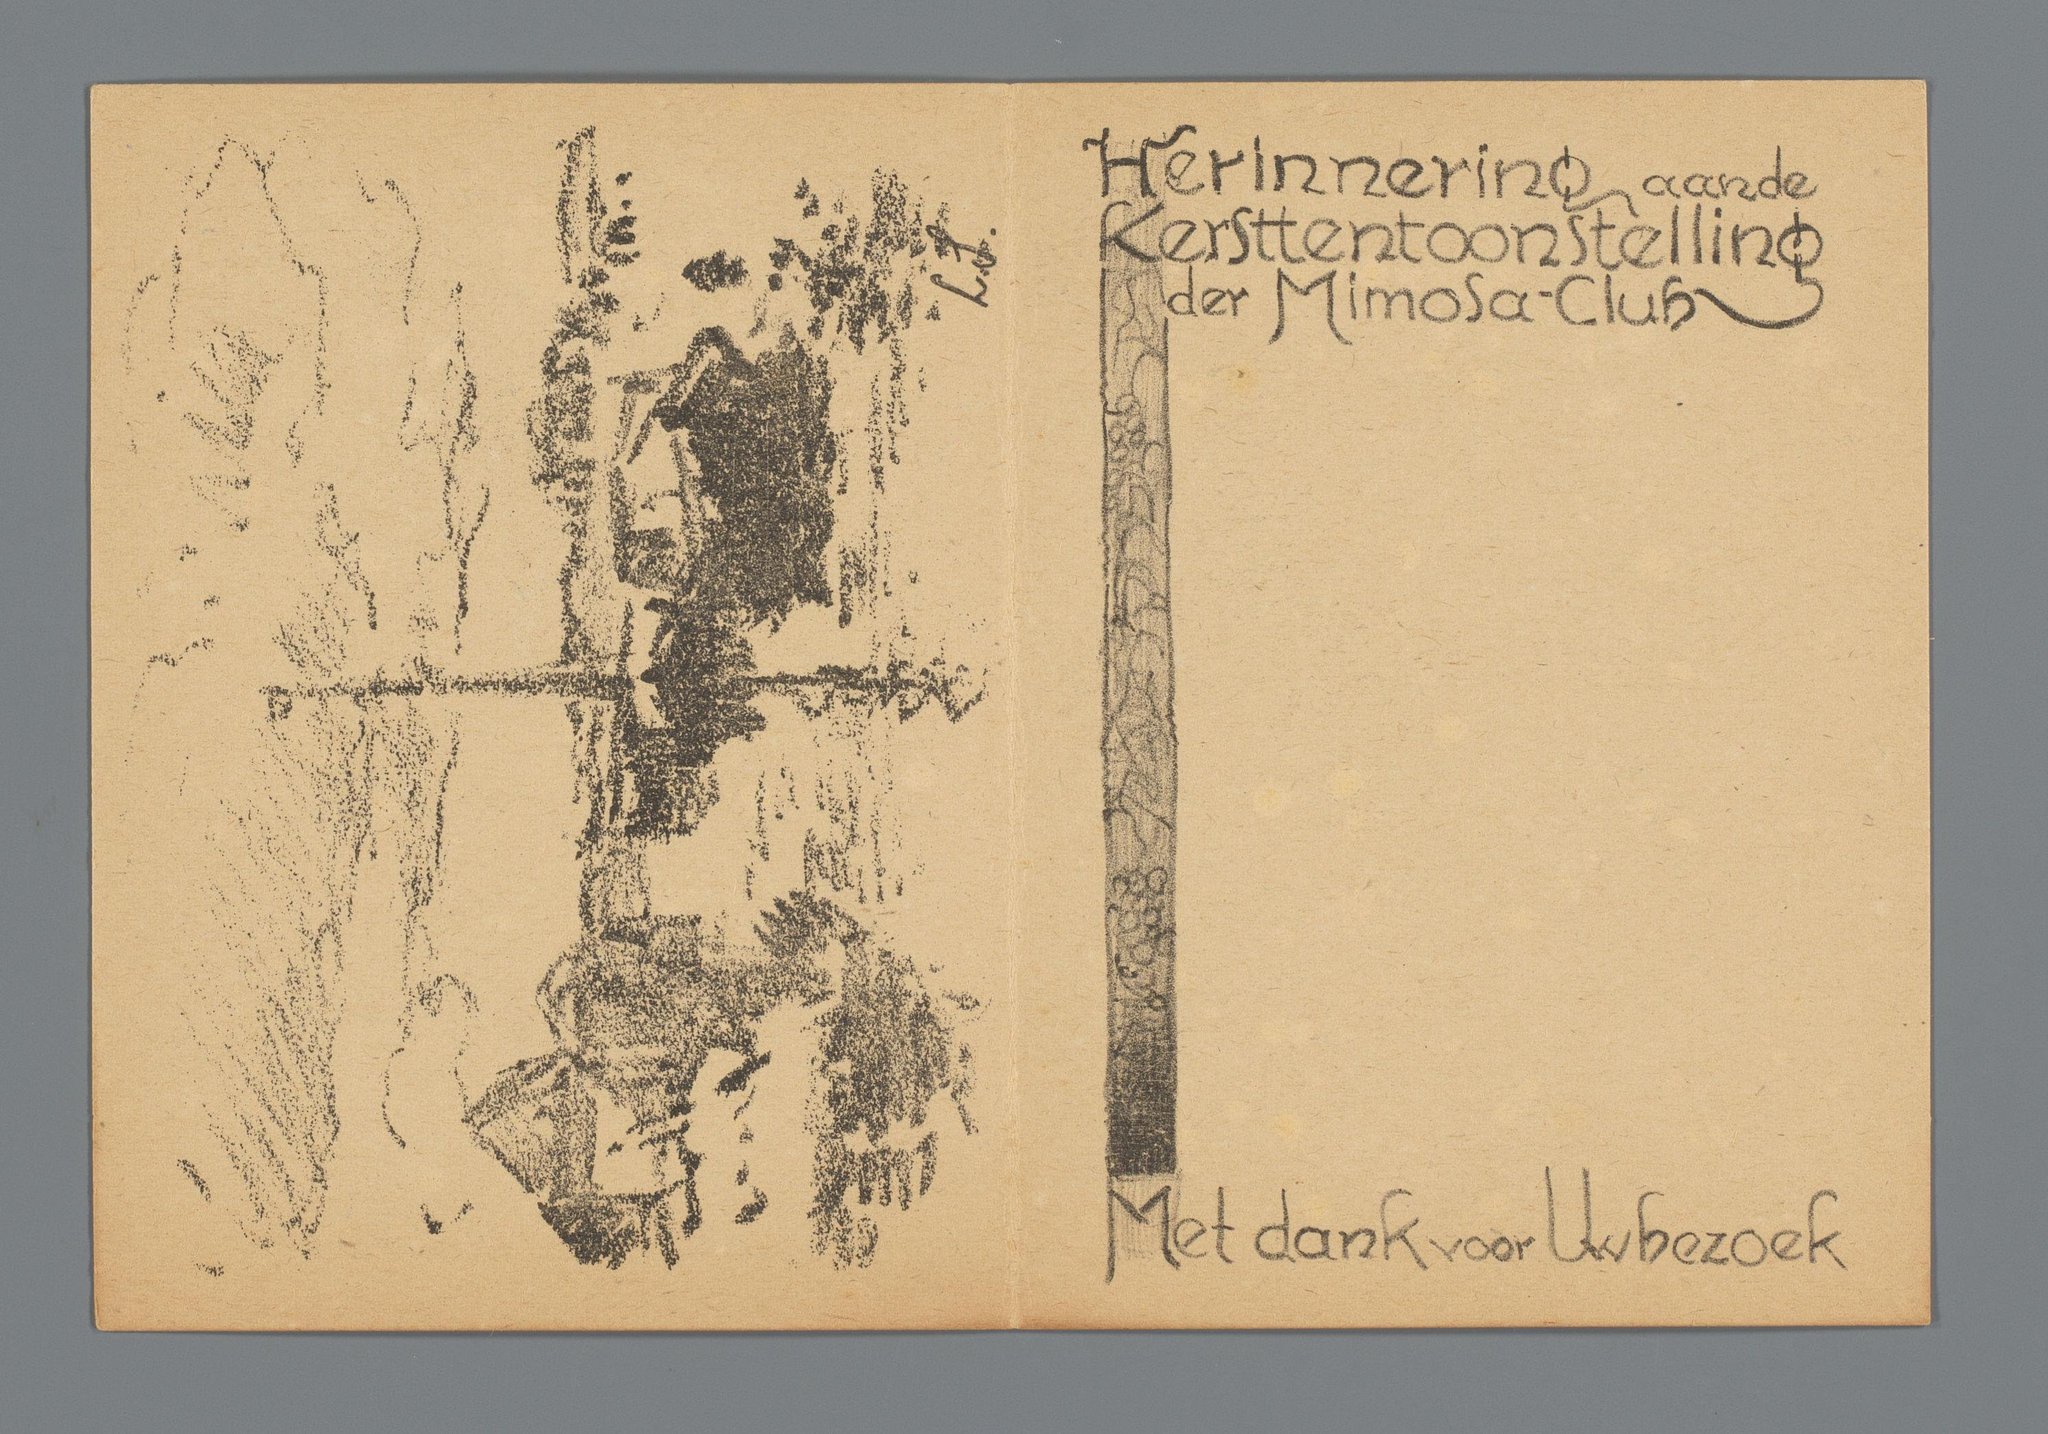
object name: print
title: Bedankkaart naar aanleiding van de kersttentoonstelling van de Mimosa-club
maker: louis stutterheim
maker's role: draughtsman, painter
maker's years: 1873-1943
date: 1883-1943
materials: paper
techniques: lithograph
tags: landscapes with waters, waterscapes, seascapes (in the temperate zone)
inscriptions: signature: ‘L.S.’